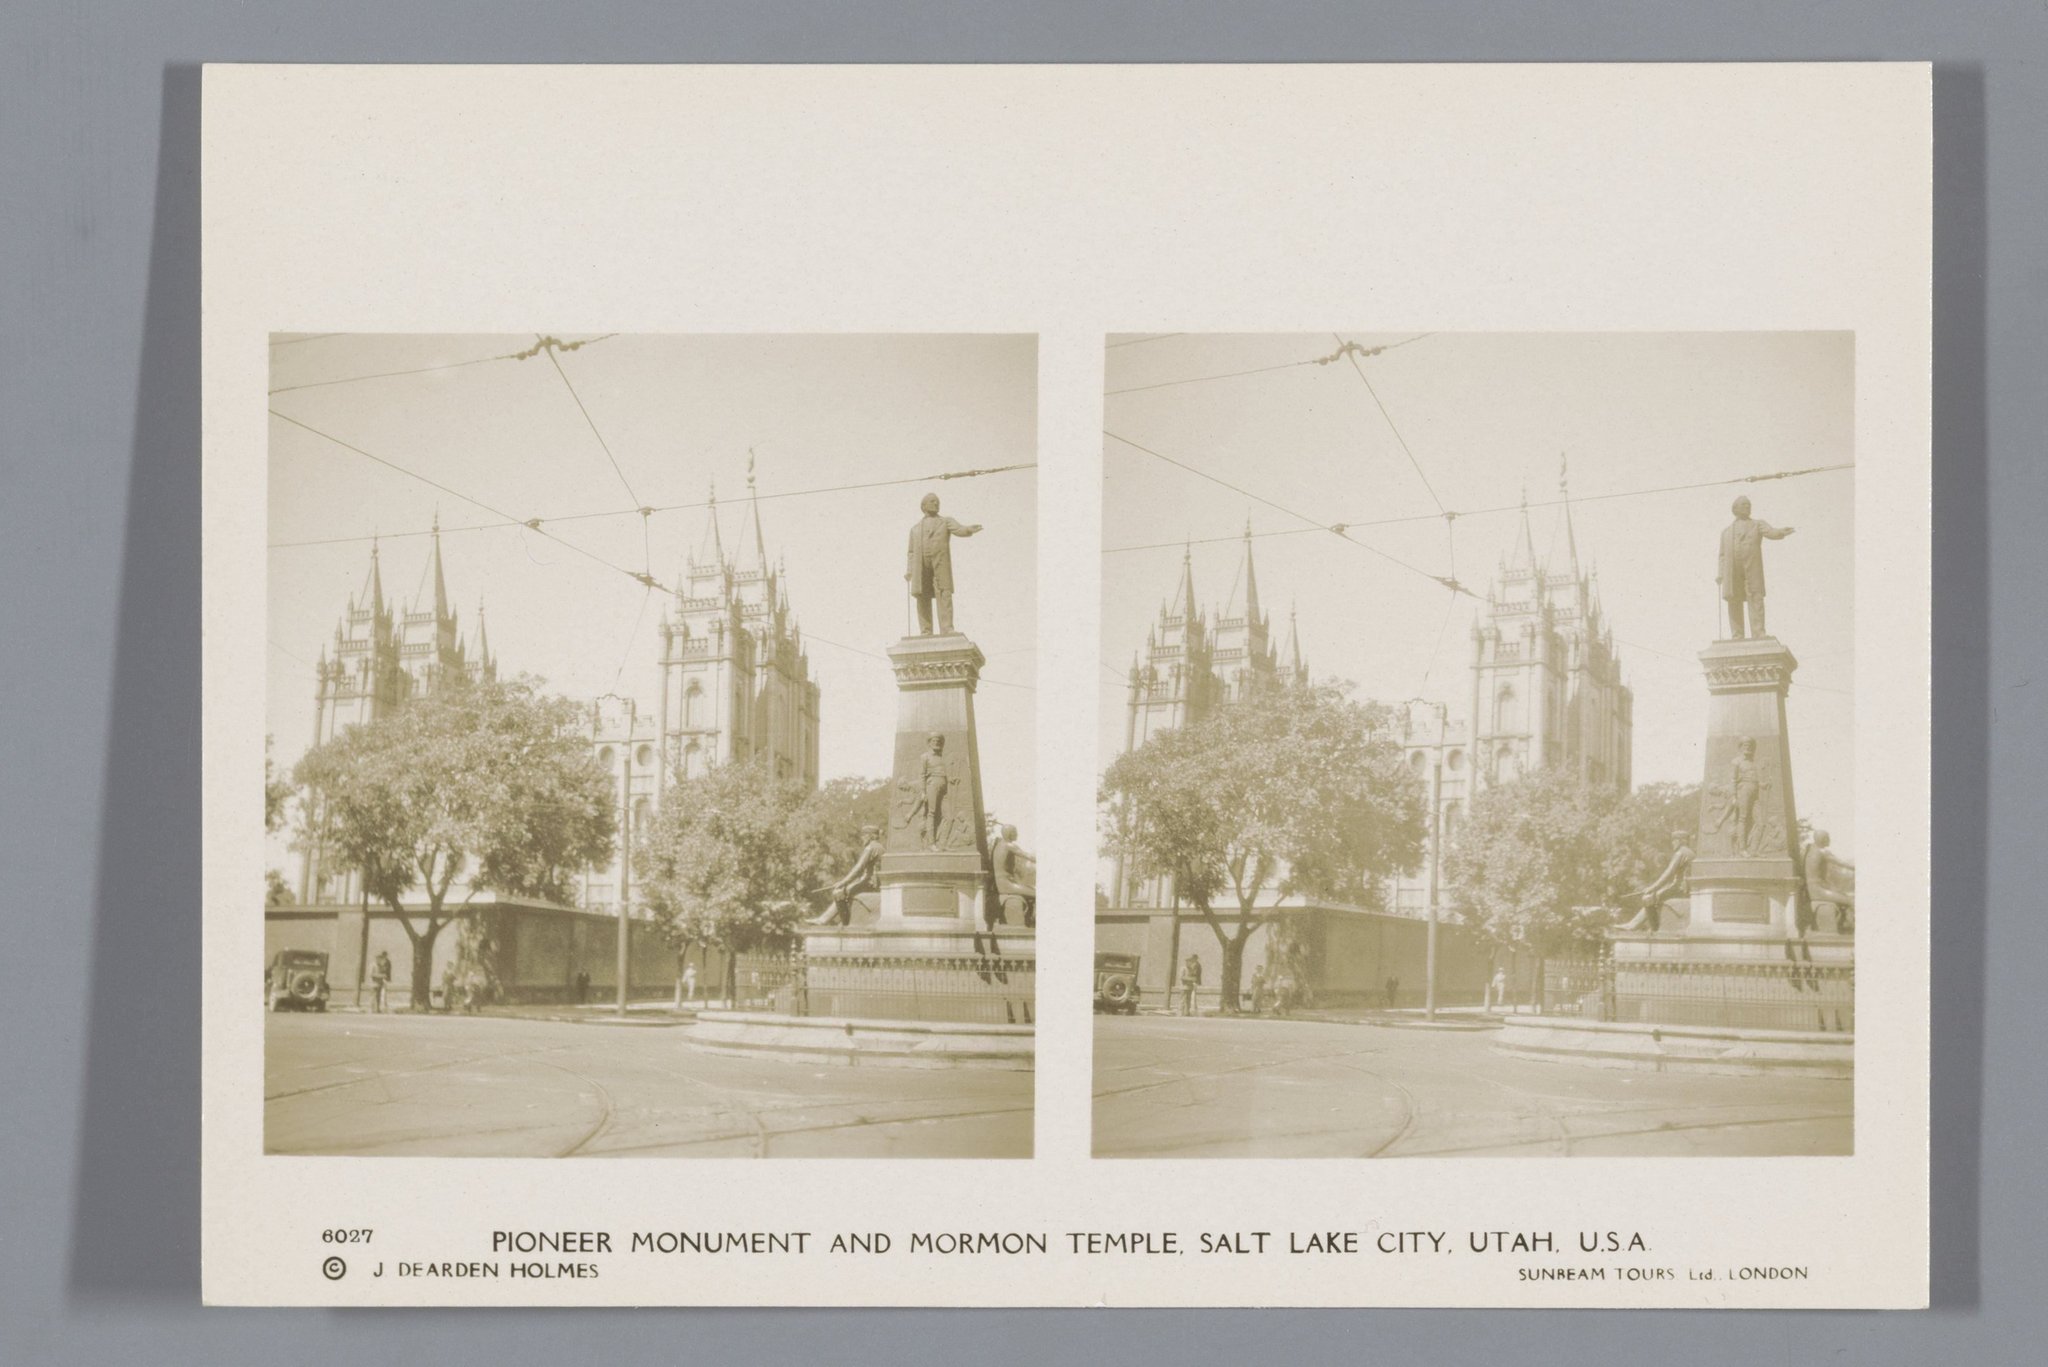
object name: stereograph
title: Pioneer Monument and Mormon Temple, Salt Lake City, Utah, U.S.A.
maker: james dearden holmes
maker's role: fotograaf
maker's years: 1873-1937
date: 1924-1926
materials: paper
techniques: gelatin silver print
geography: london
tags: movements derived from protestant churches (with name), monument, statue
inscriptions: number: ‘6027’